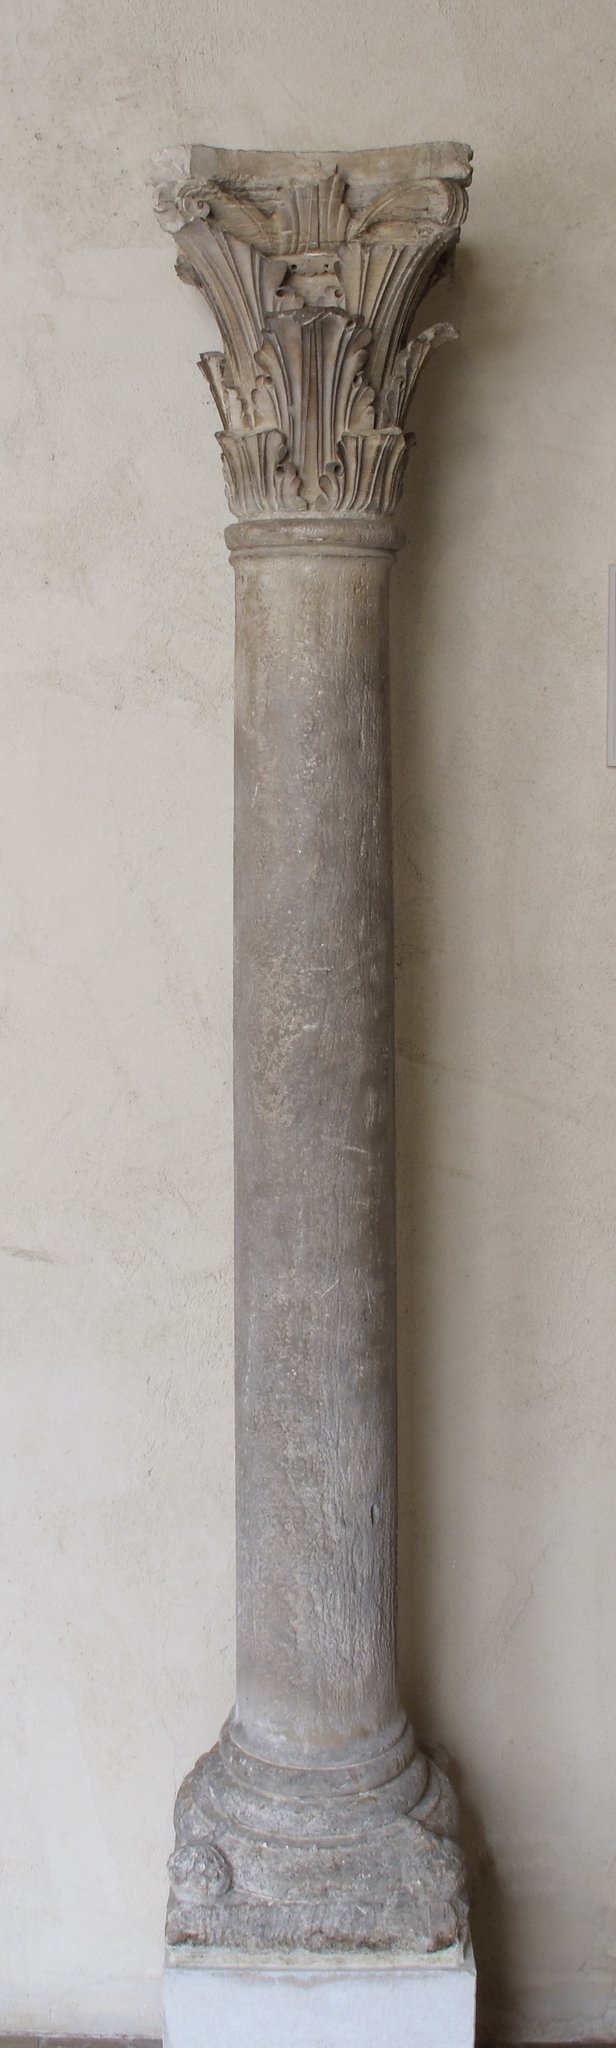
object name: shaft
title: Column Shaft and Base (from ensemble of Capital, Shaft, and Base)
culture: french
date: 1167-1200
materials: limestone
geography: france